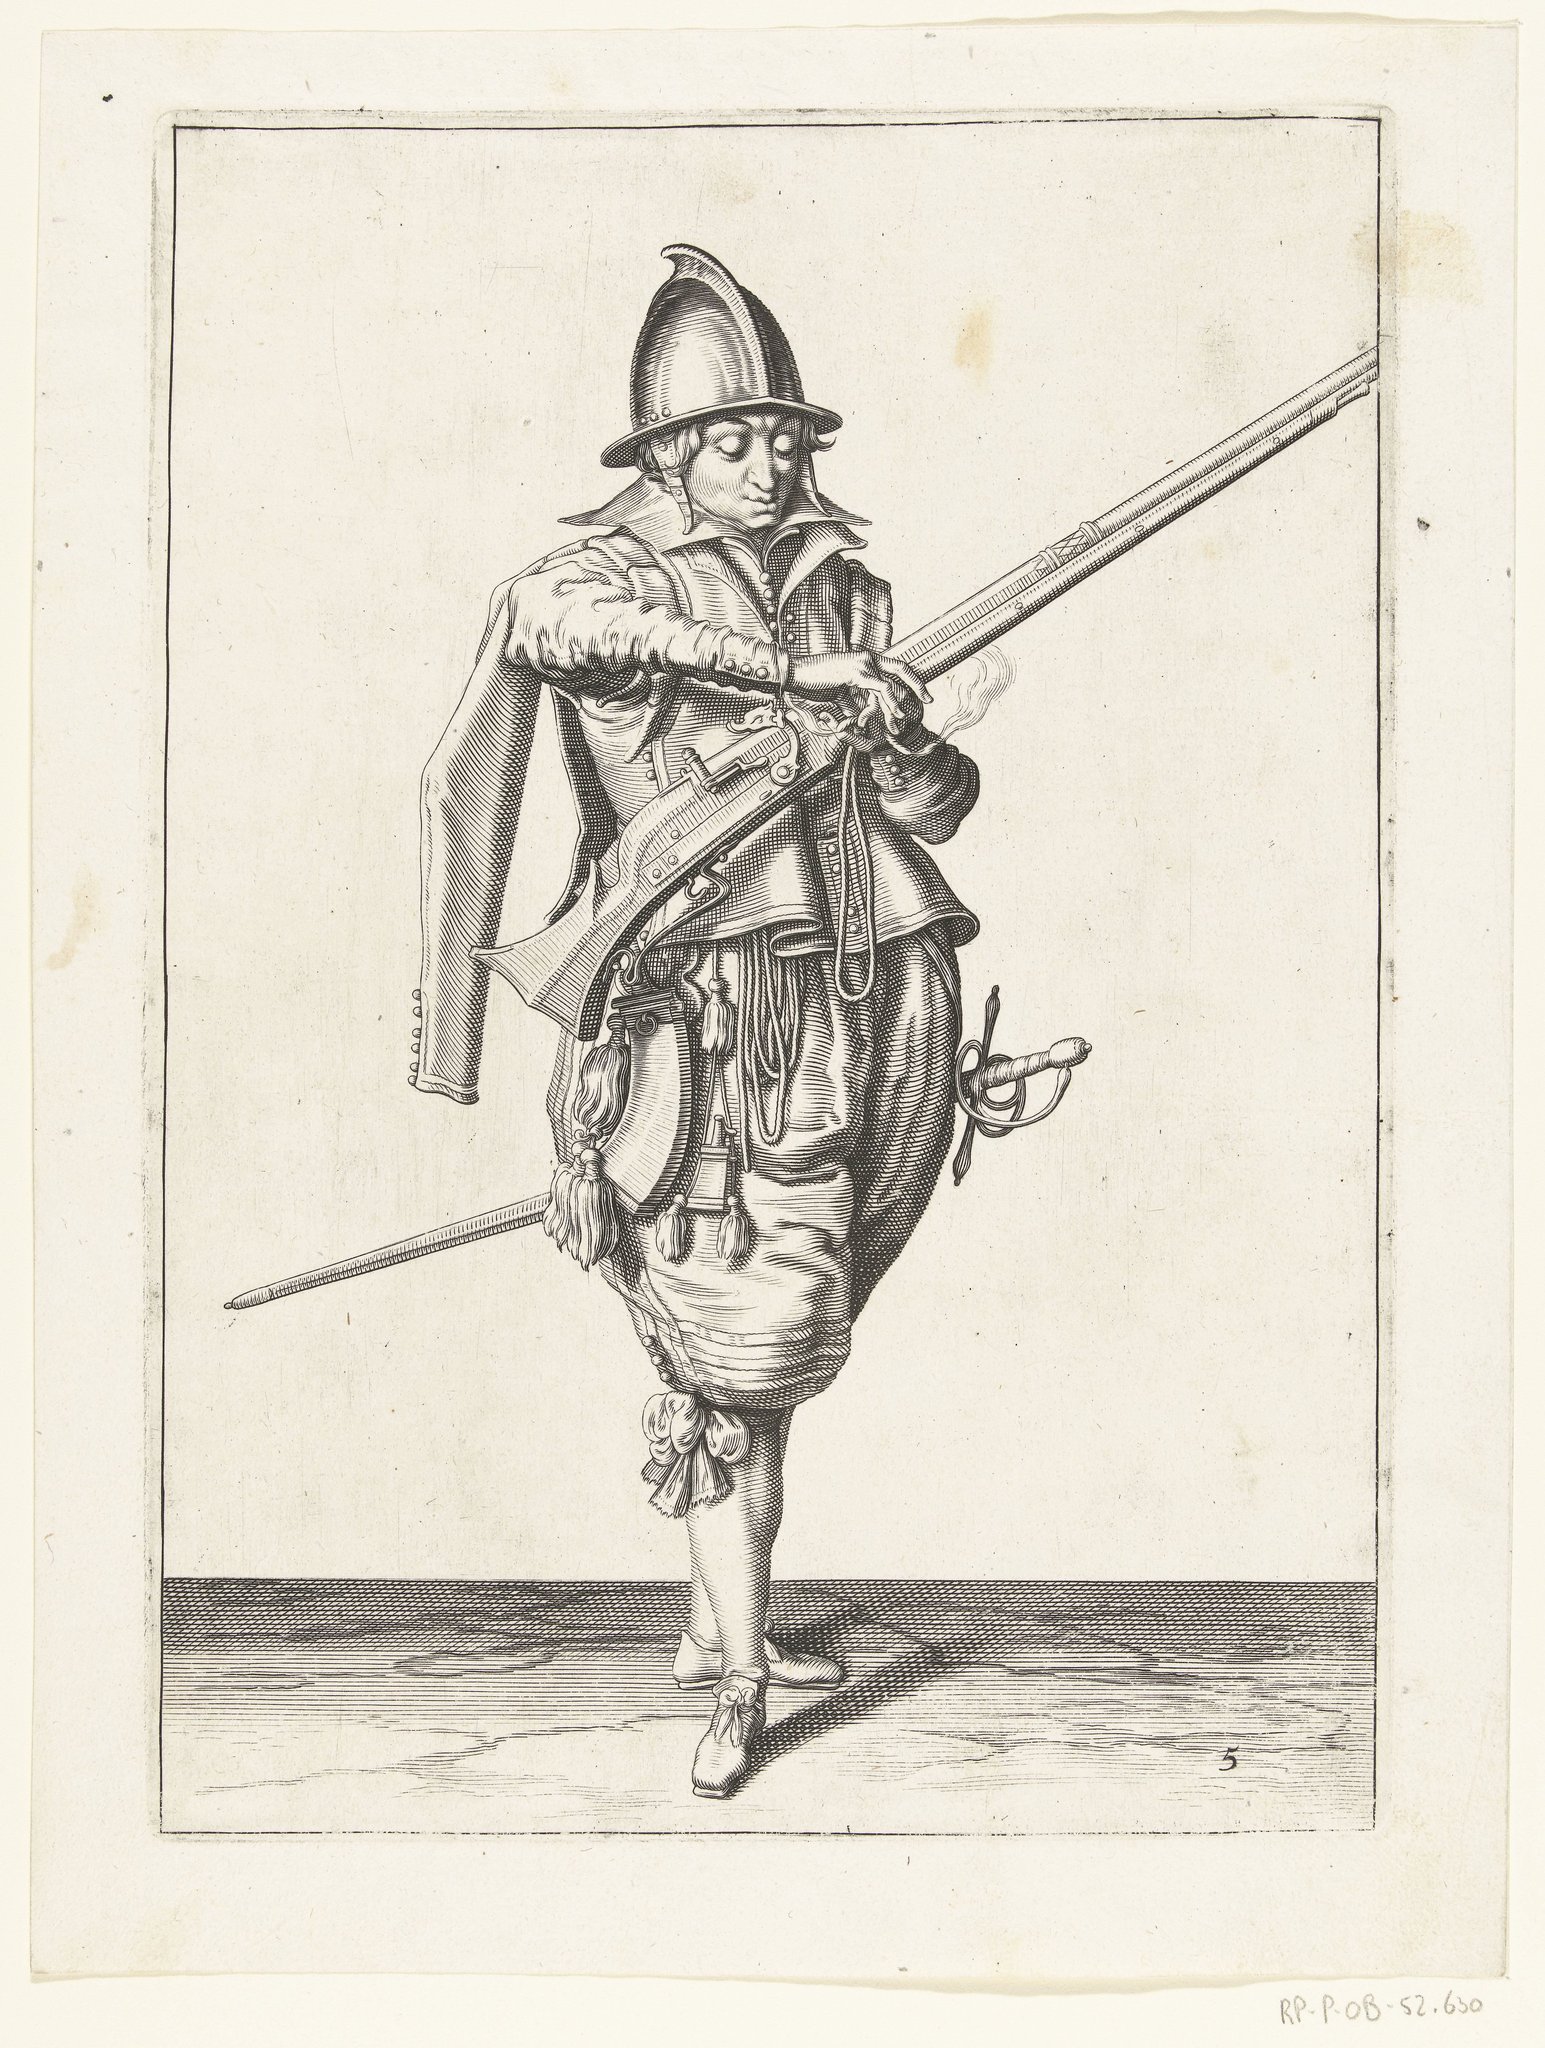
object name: print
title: Soldaat met een roer die zijn lont pakt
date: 1597-1607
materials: paper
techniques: engraving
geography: netherlands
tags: manoeuvre ~ military training, firearms: rifle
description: Een soldaat, ten voeten uit, naar rechts, die een roer (een bepaald type vuurwapen) met zijn linkerhand vasthoudt. In zijn linkerhand behalve het roer ook een brandende lont. Met zijn rechterhand pakt hij deze lont. Deze prent is onderdeel van de reeks van 42 genummerde prenten van roerschutters uit de Wapenhandelinghe.